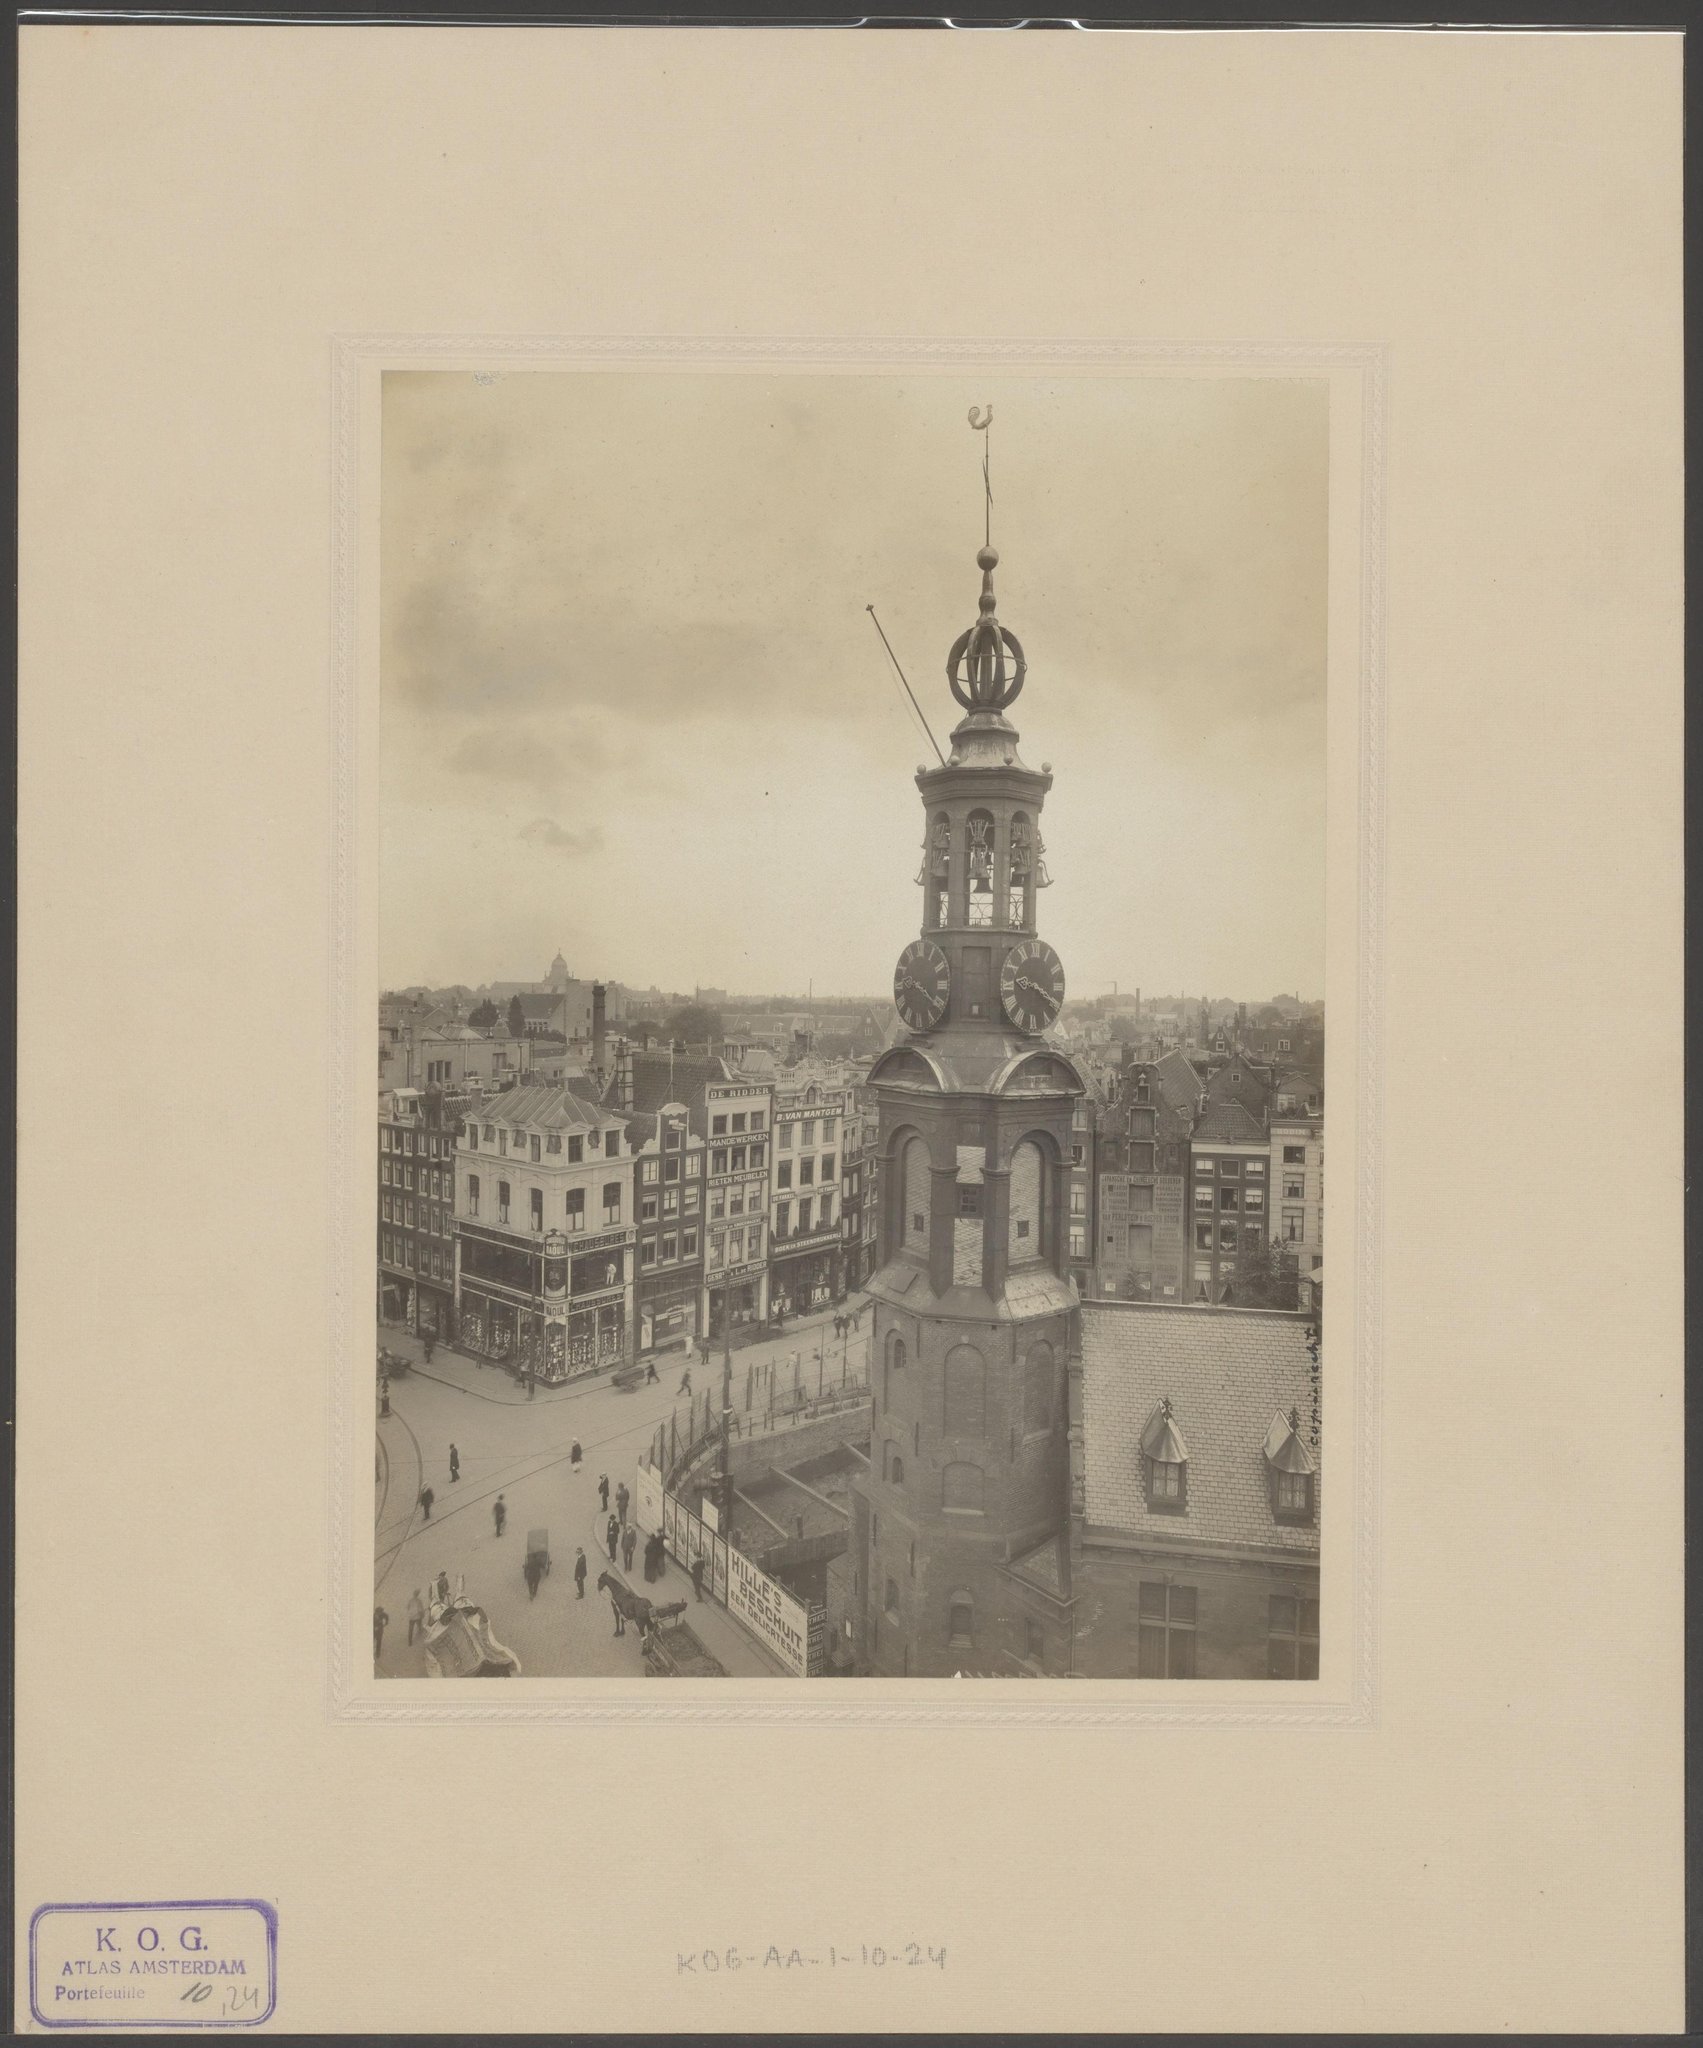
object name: photograph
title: Gezicht op het Muntplein met de Munttoren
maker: cornelis johannes steenbergh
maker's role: fotograaf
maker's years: 1859-1939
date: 1890-1939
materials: paper, cardboard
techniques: gelatin silver print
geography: amsterdam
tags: square, place, circus, etc., tramway, tram, tower, clock tower ~ monumental adornment, city-view in general; 'veduta'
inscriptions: collector's mark: ‘10,24’ Lugt 1641b, signature: ‘foto. C. Steenbergh / Overtoom 21.’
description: Onderwerpsrubriek binnen de Atlas Amsterdam: Maagdelievenstraat, Markenplein, Marnixstraat, Martelaarsgracht, Meeuwenlaan, Mennonietenpad, Meijerplein (Jonas Daniël), Mozes en Aäronstraat, Muidergracht, Muntplein.